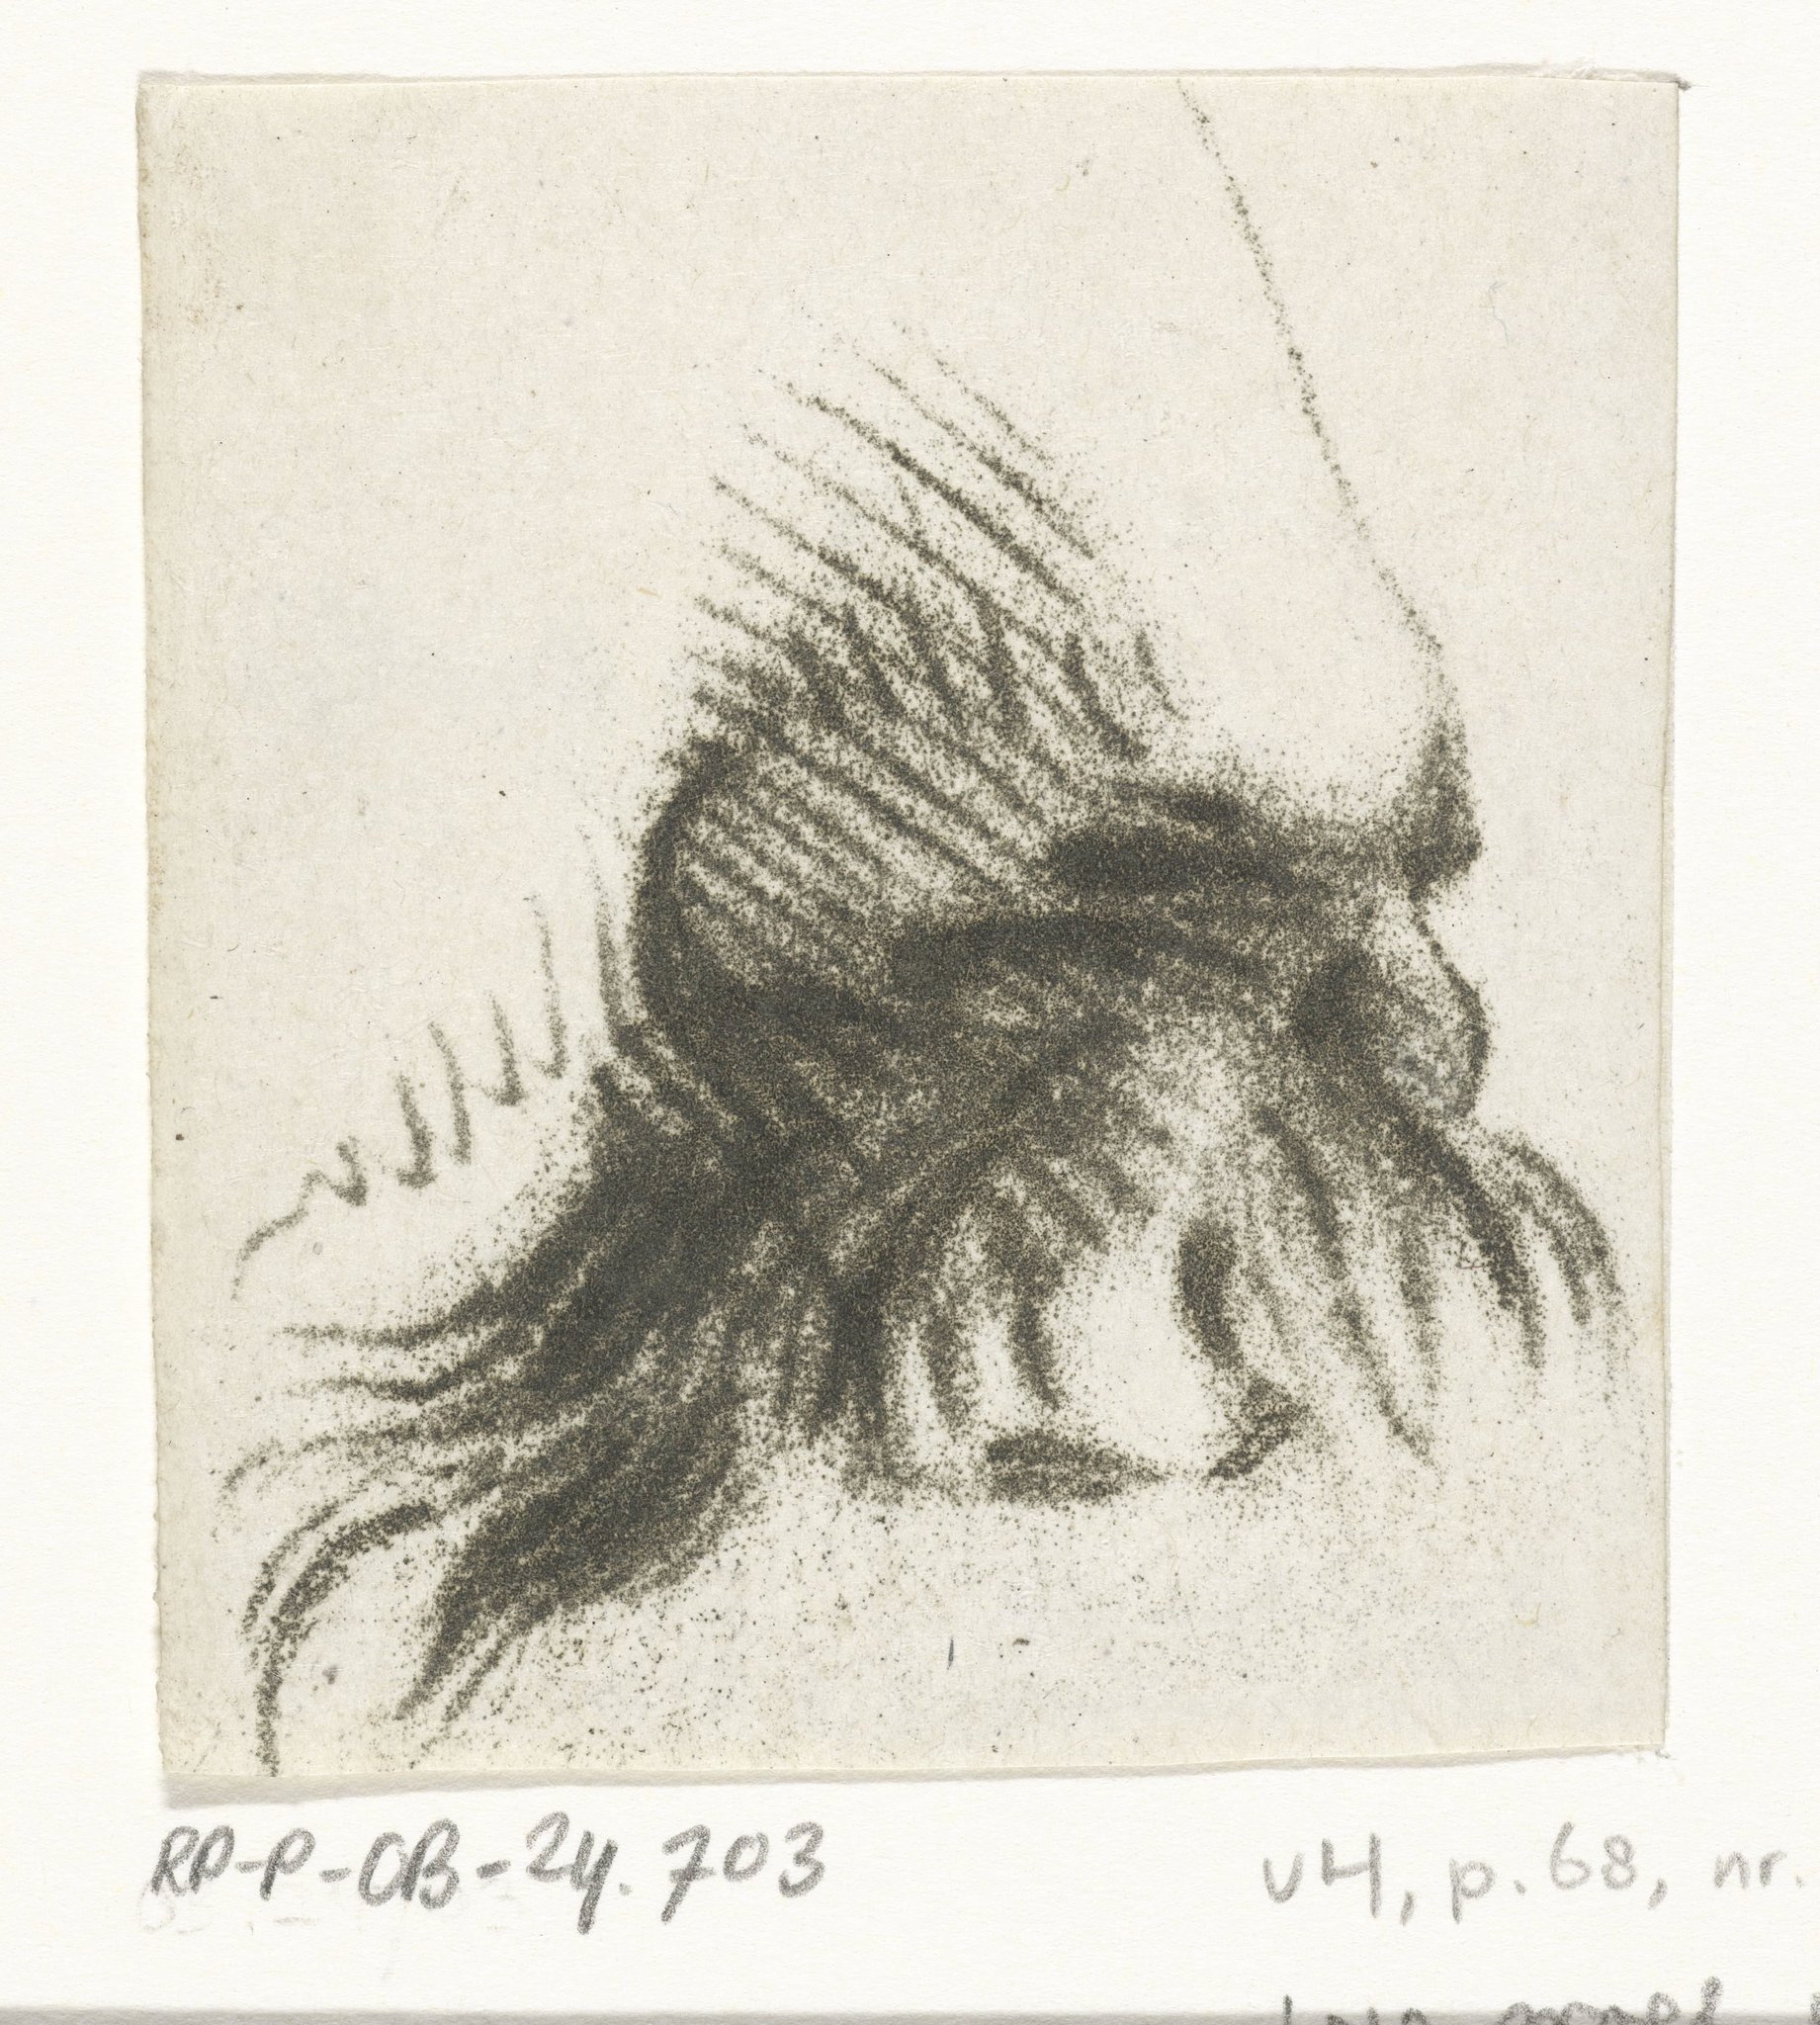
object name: print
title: Neus met snor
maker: cornelis ploos van amstel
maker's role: draughtsman, print maker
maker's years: 1726-1798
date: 1756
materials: paper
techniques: printmaking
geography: amsterdam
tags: moustache, parts of the face: nose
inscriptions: inscription: ‘Geoff Aan d Wel Ed Heer en neef J v Dussen 1772 // G vd Myn del Ploos v Amstel JC F 1756.’, collector's mark: Lugt 240